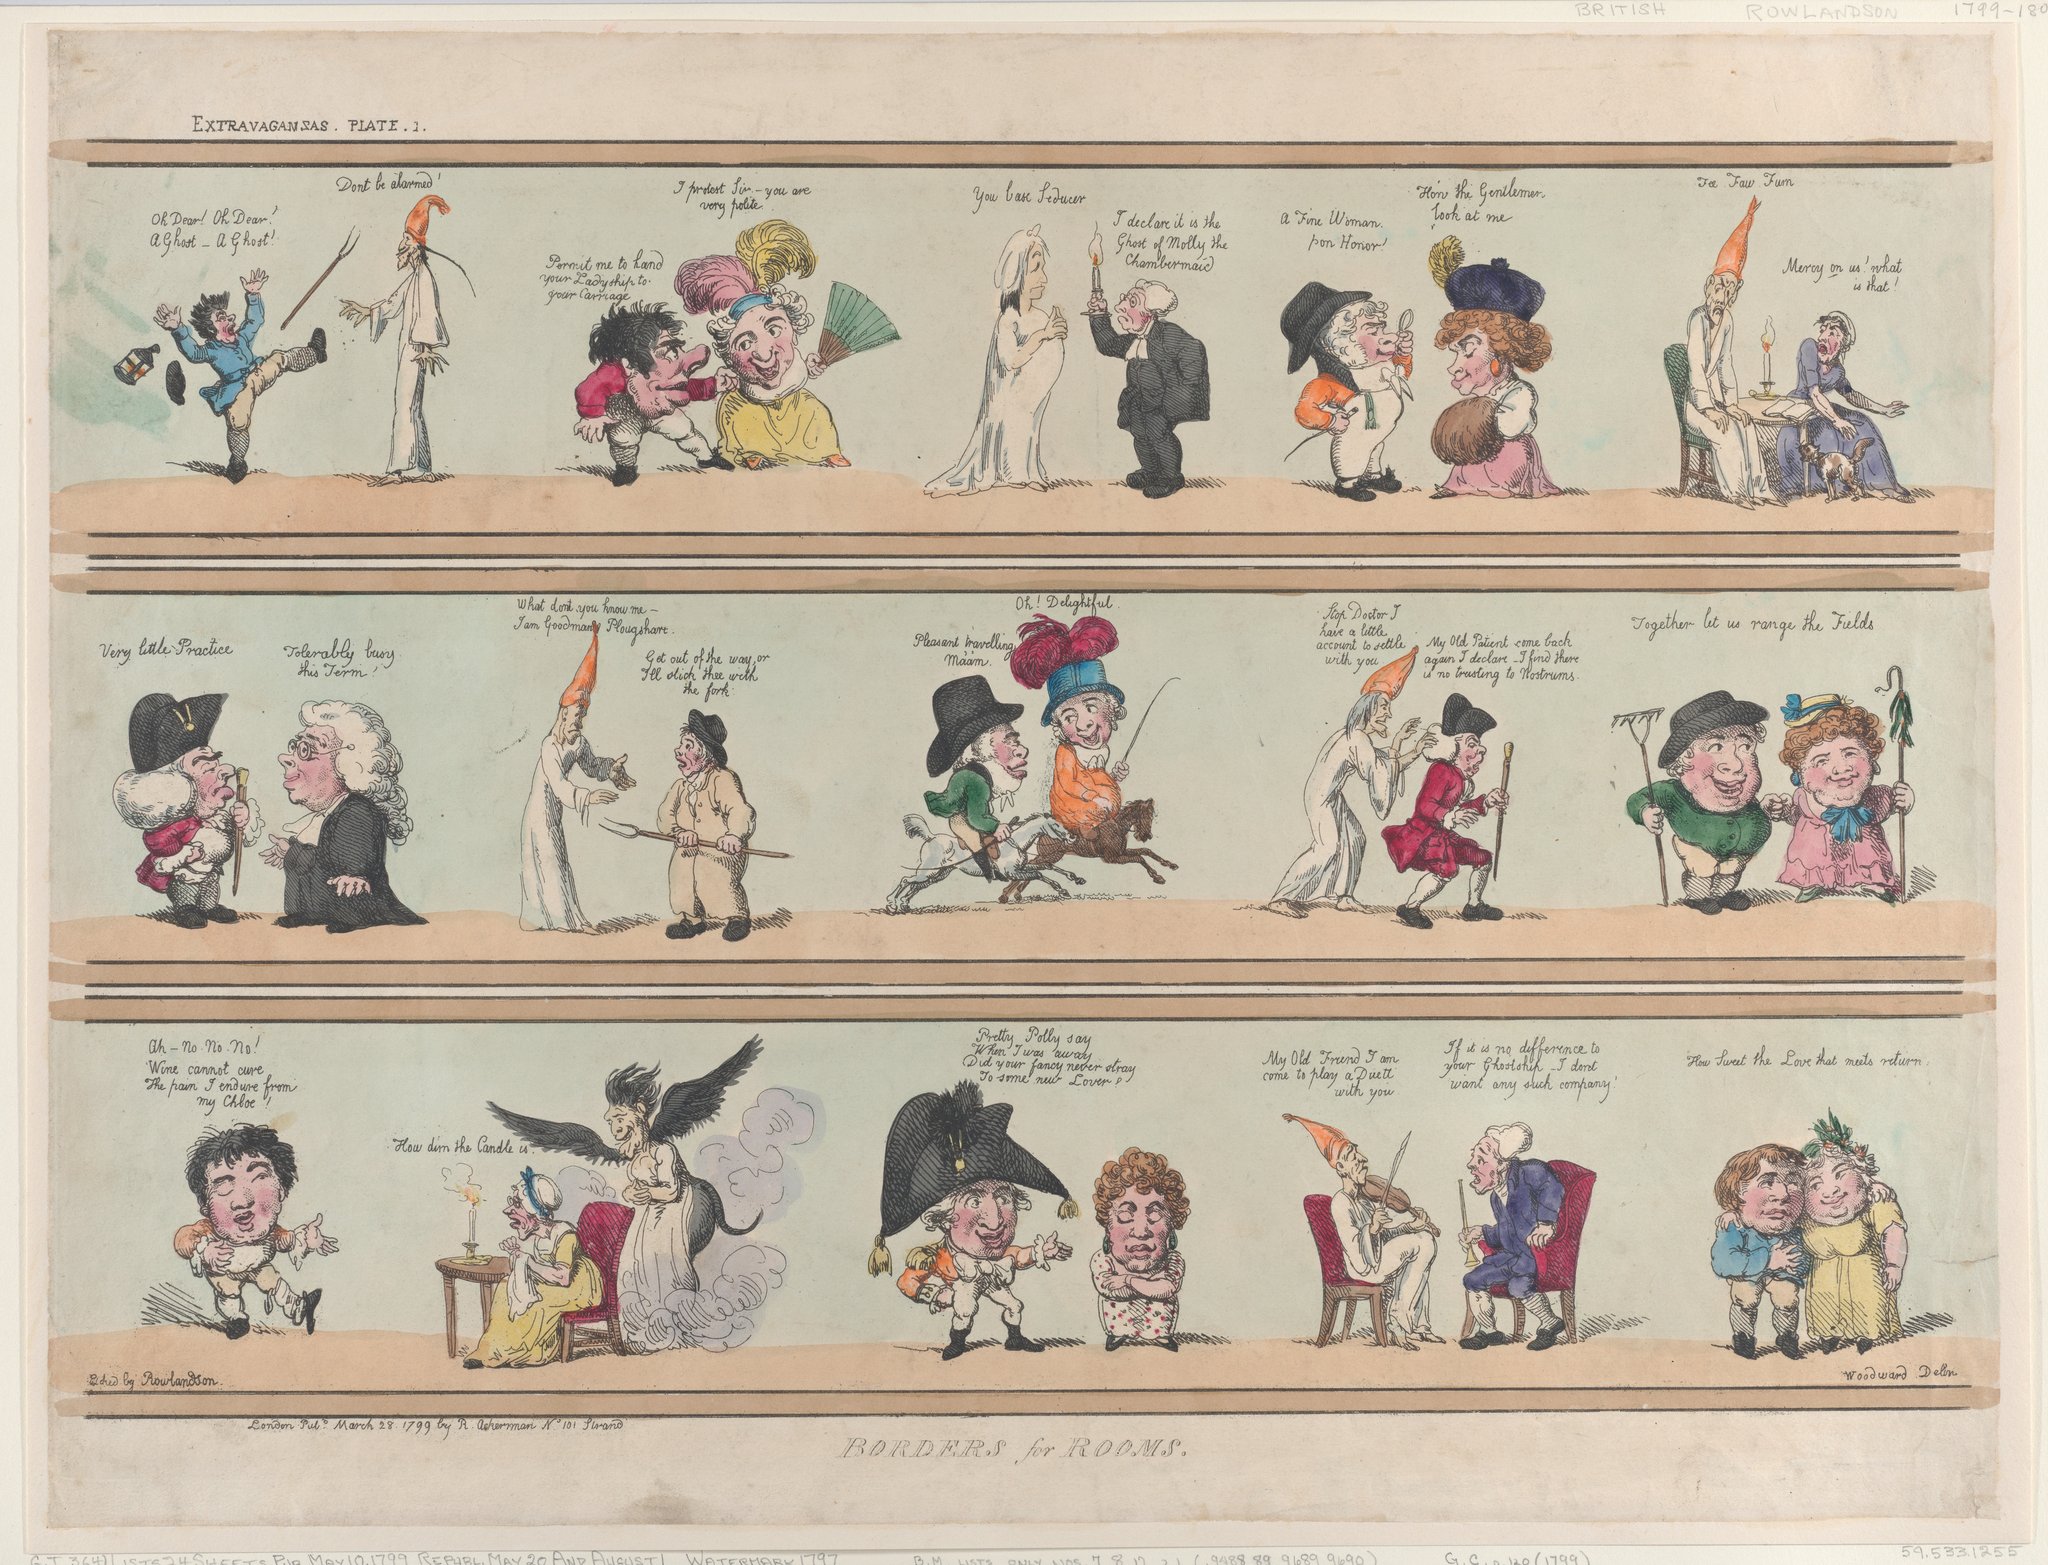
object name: print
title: Borders for Rooms, Extravaganzas Plate 1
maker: thomas rowlandson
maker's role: artist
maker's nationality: british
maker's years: 1757-1827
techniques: etching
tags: satire,men,women